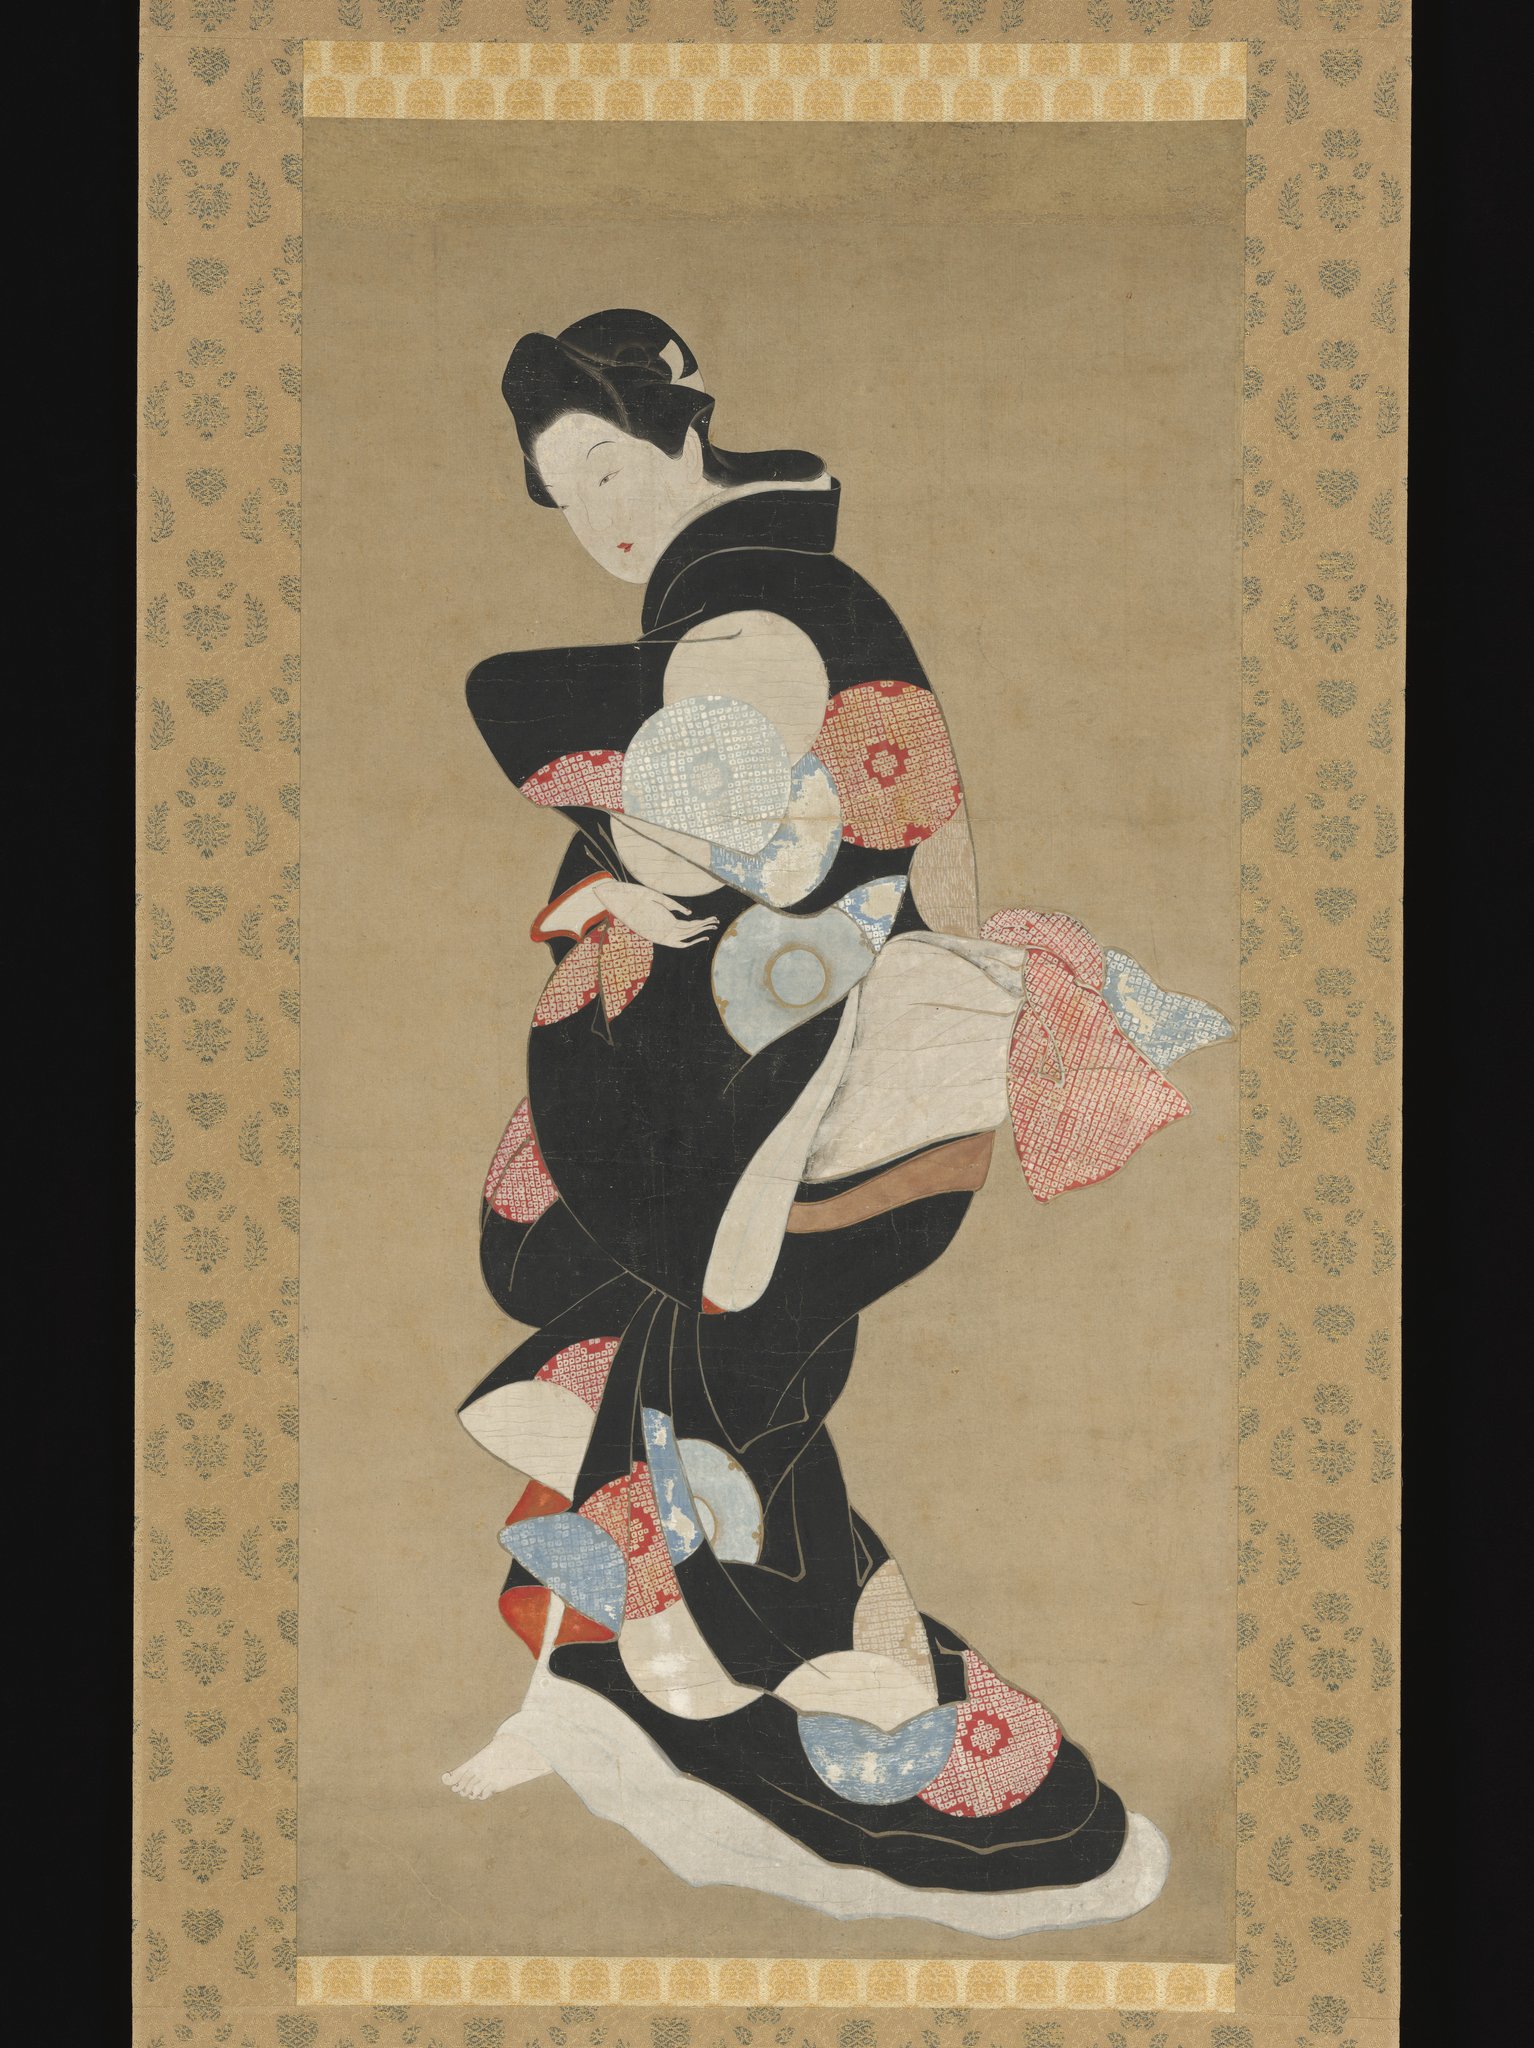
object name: hanging scroll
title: Dancer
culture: japanese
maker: hishikawa moronobu 菱川師宣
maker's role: artist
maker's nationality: japanese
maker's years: 1618-1694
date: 1618-1694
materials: paper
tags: women,dancers